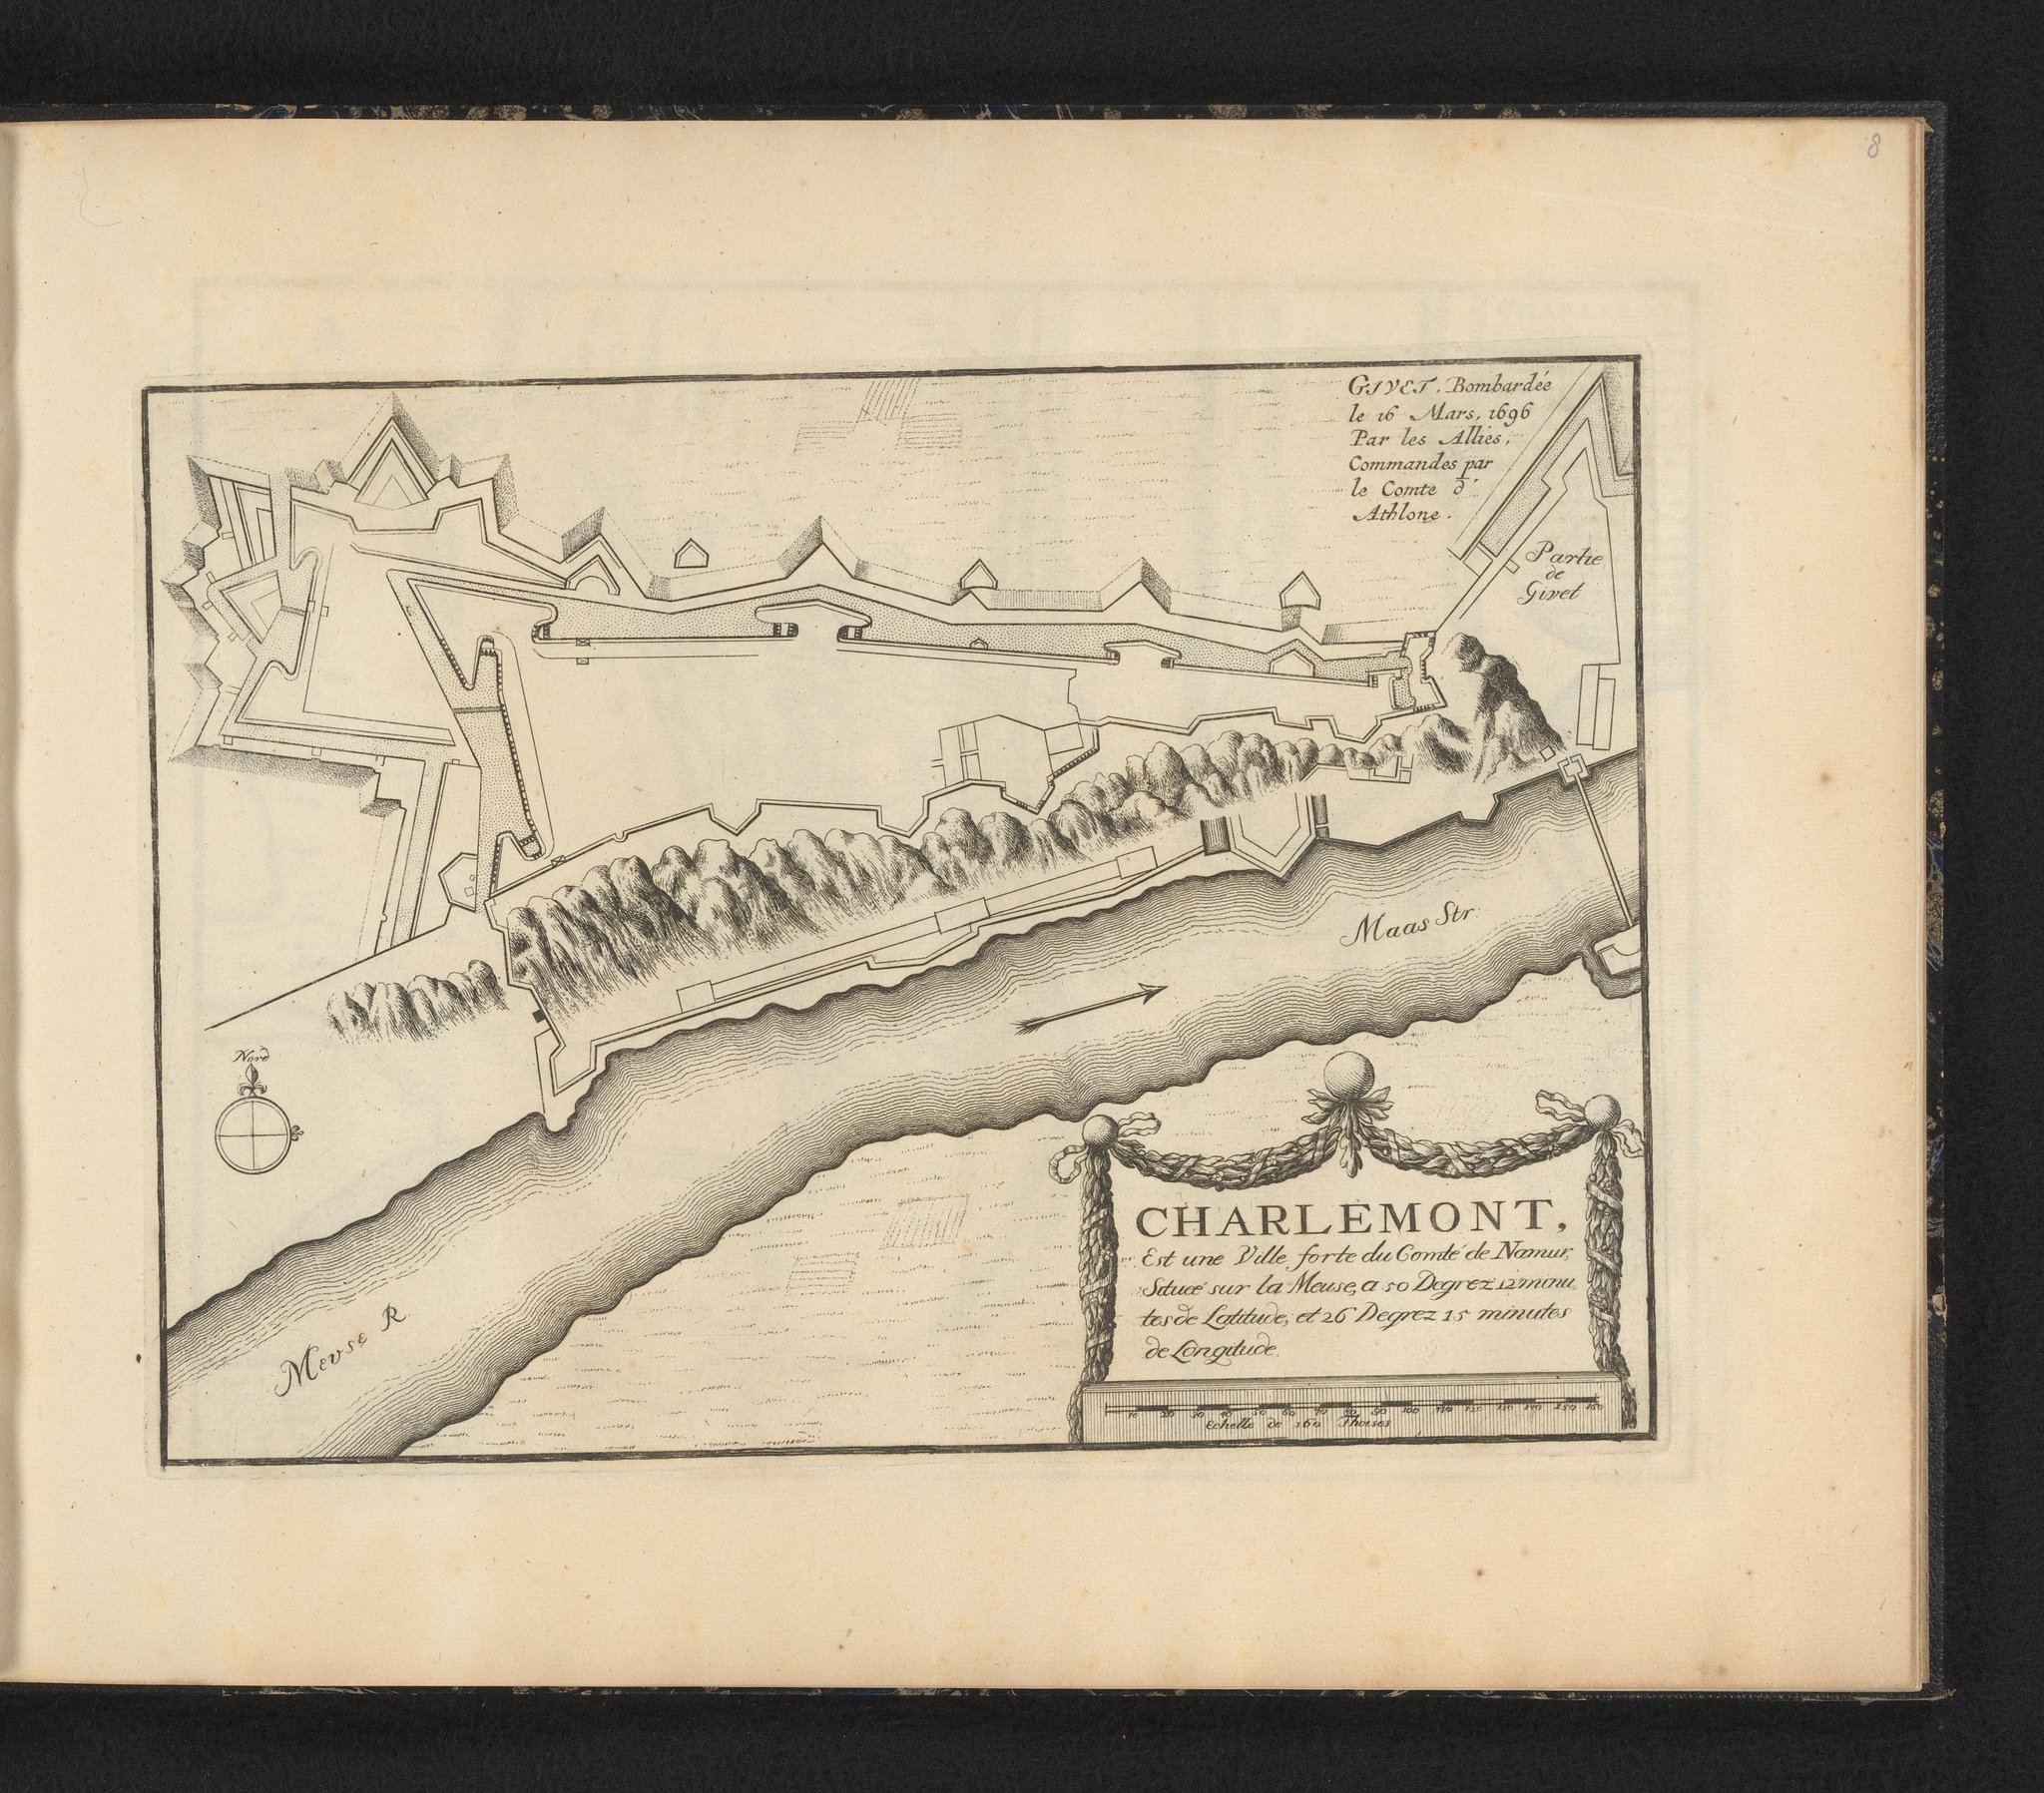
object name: print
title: Charlemont, Est une Ville forte du Comté de Namur (...)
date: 1696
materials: paper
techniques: etching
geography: paris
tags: fortress, maps of cities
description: Plattegrond van de versterkingen van het fort Charlemont bij de stad Givet aan de Maas in de graafschap Namen. Beschoten door de geallieerden op 16 maart 1696. Maakt deel uit van het eerste deel van het prentwerk: Le Theatre de la Guerre, dans les Pays-Bas, uitgegeven in 1696. Dit deel bevat 25 platen met plannen (afkomstig van Sébastien Le Prestre, Seigneur de Vauban) van vermaarde sterke steden en vestingen in de Negenjarige Oorlog in de Nederlanden. Titel en opschriften in het Frans.